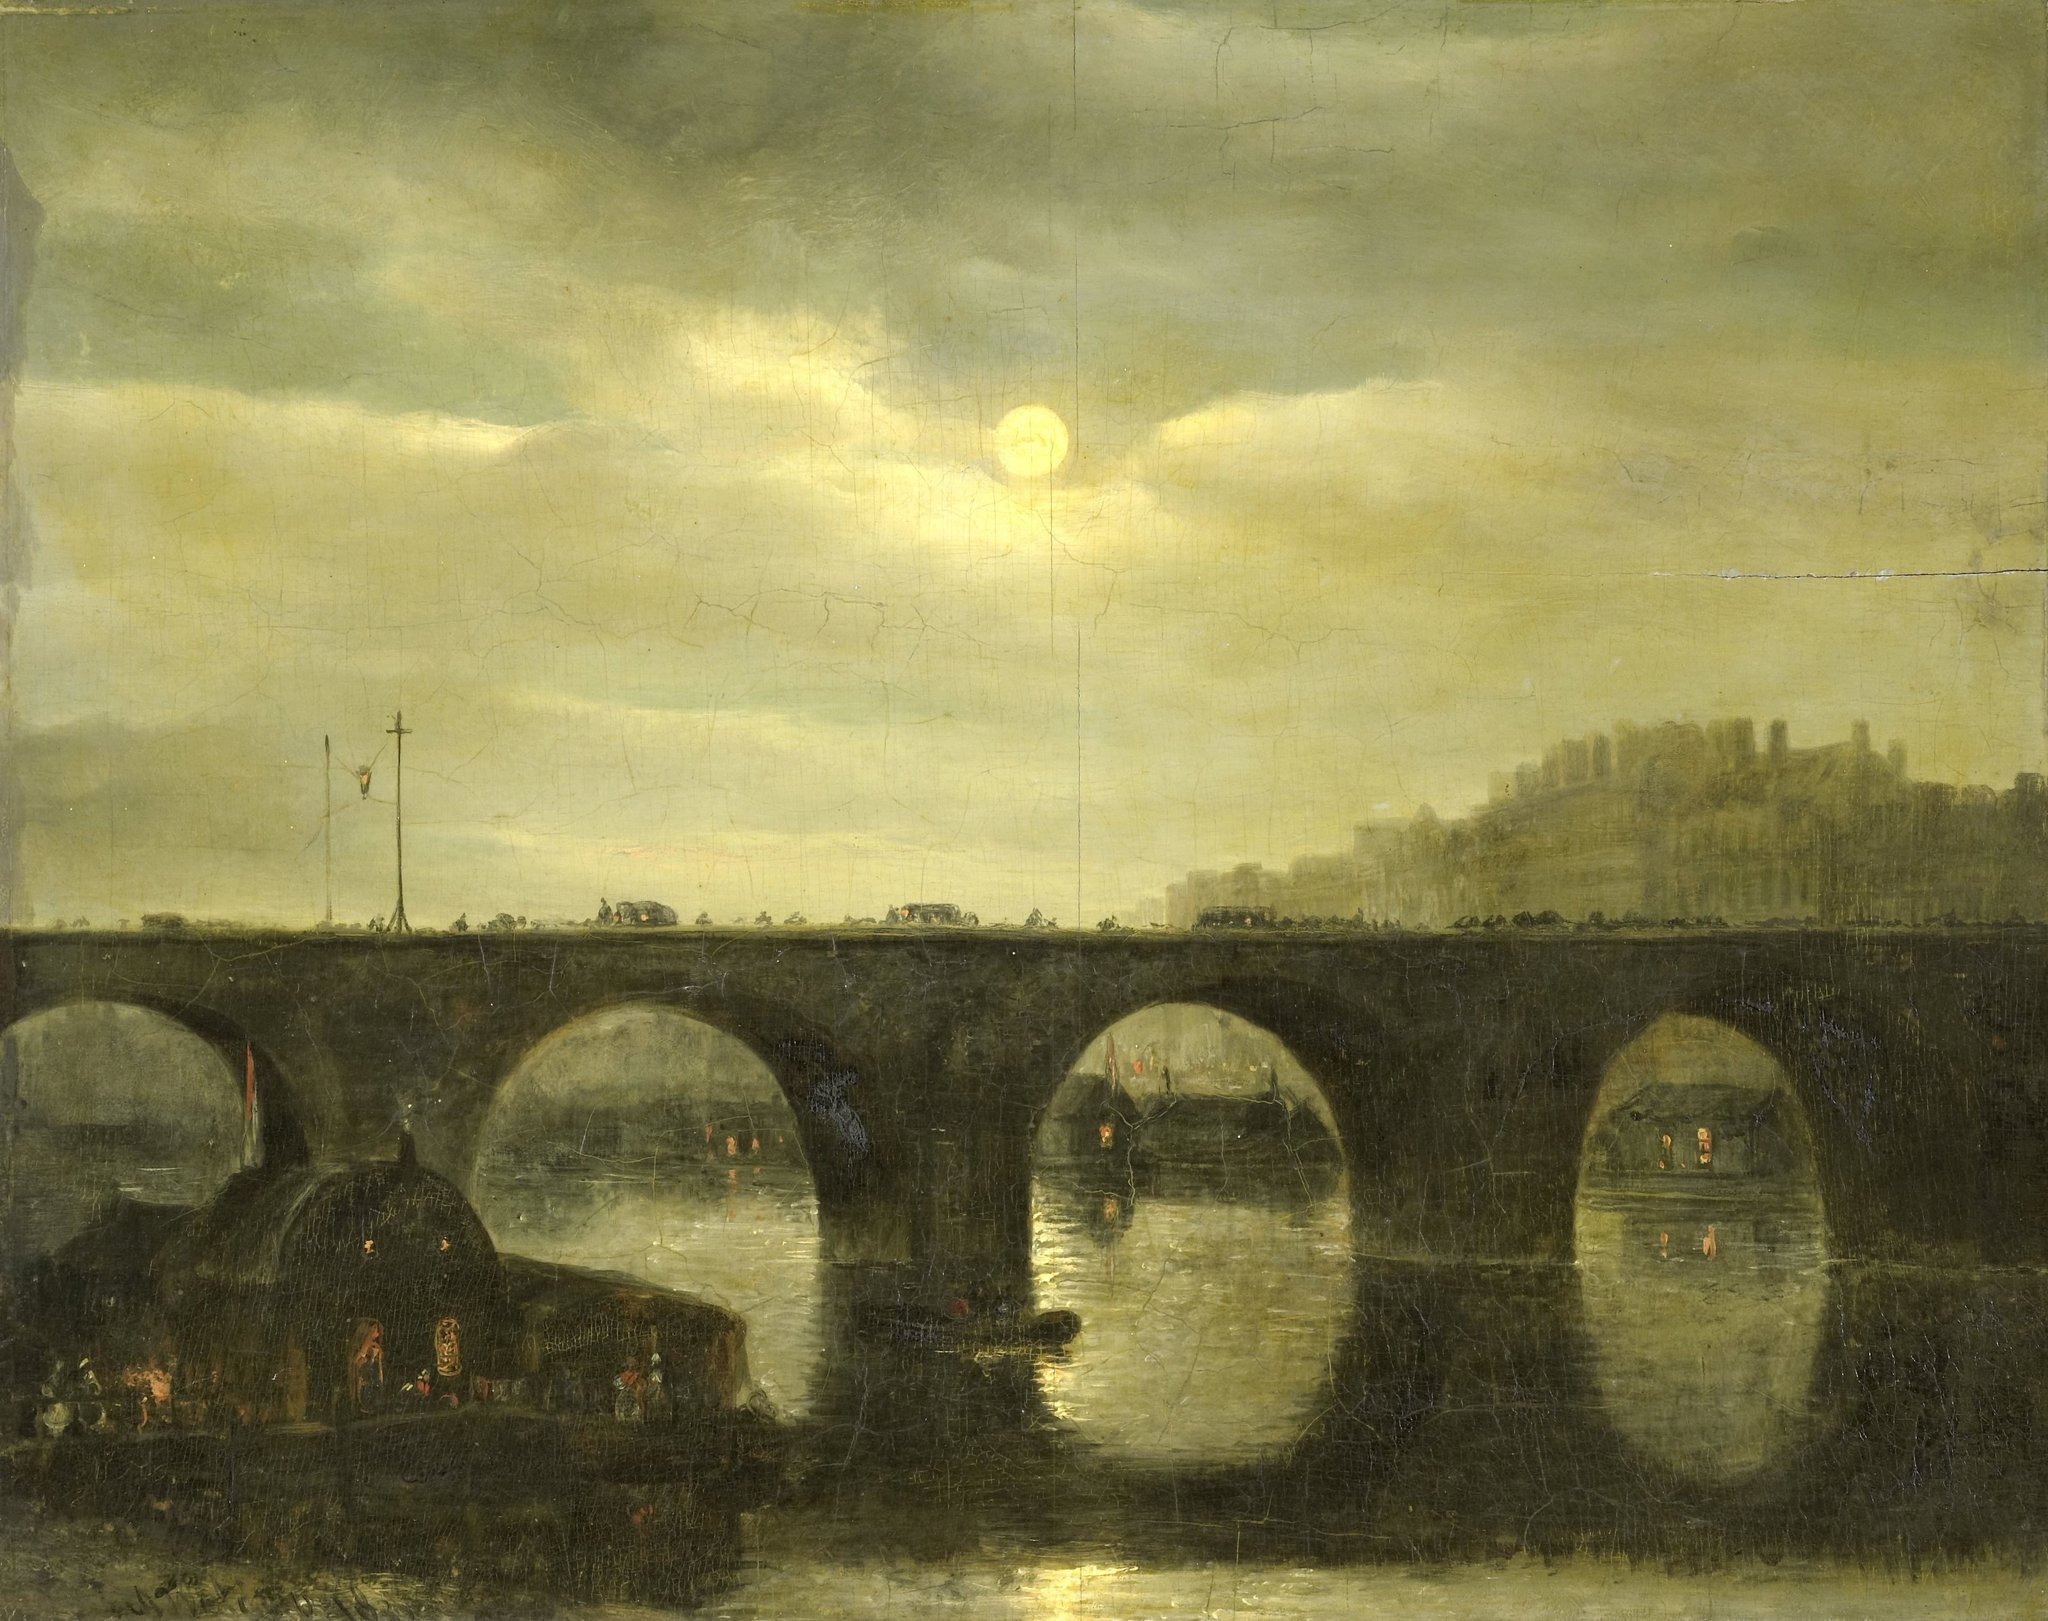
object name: painting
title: One of the Bridges over the Seine, Paris, in the Moonlight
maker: antonie waldorp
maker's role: draughtsman, painter, print maker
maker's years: 1803-1866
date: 1835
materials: oil, panel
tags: moonlight, bridge in city across river, canal, etc., paris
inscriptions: signature and date: ‘A. Waldorp 1835 [?]’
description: Gezicht op een brug over de Seine te Parijs bij maanlicht. Aan de oevers van de rivier staan enkele verlichte huizen en schuiten.